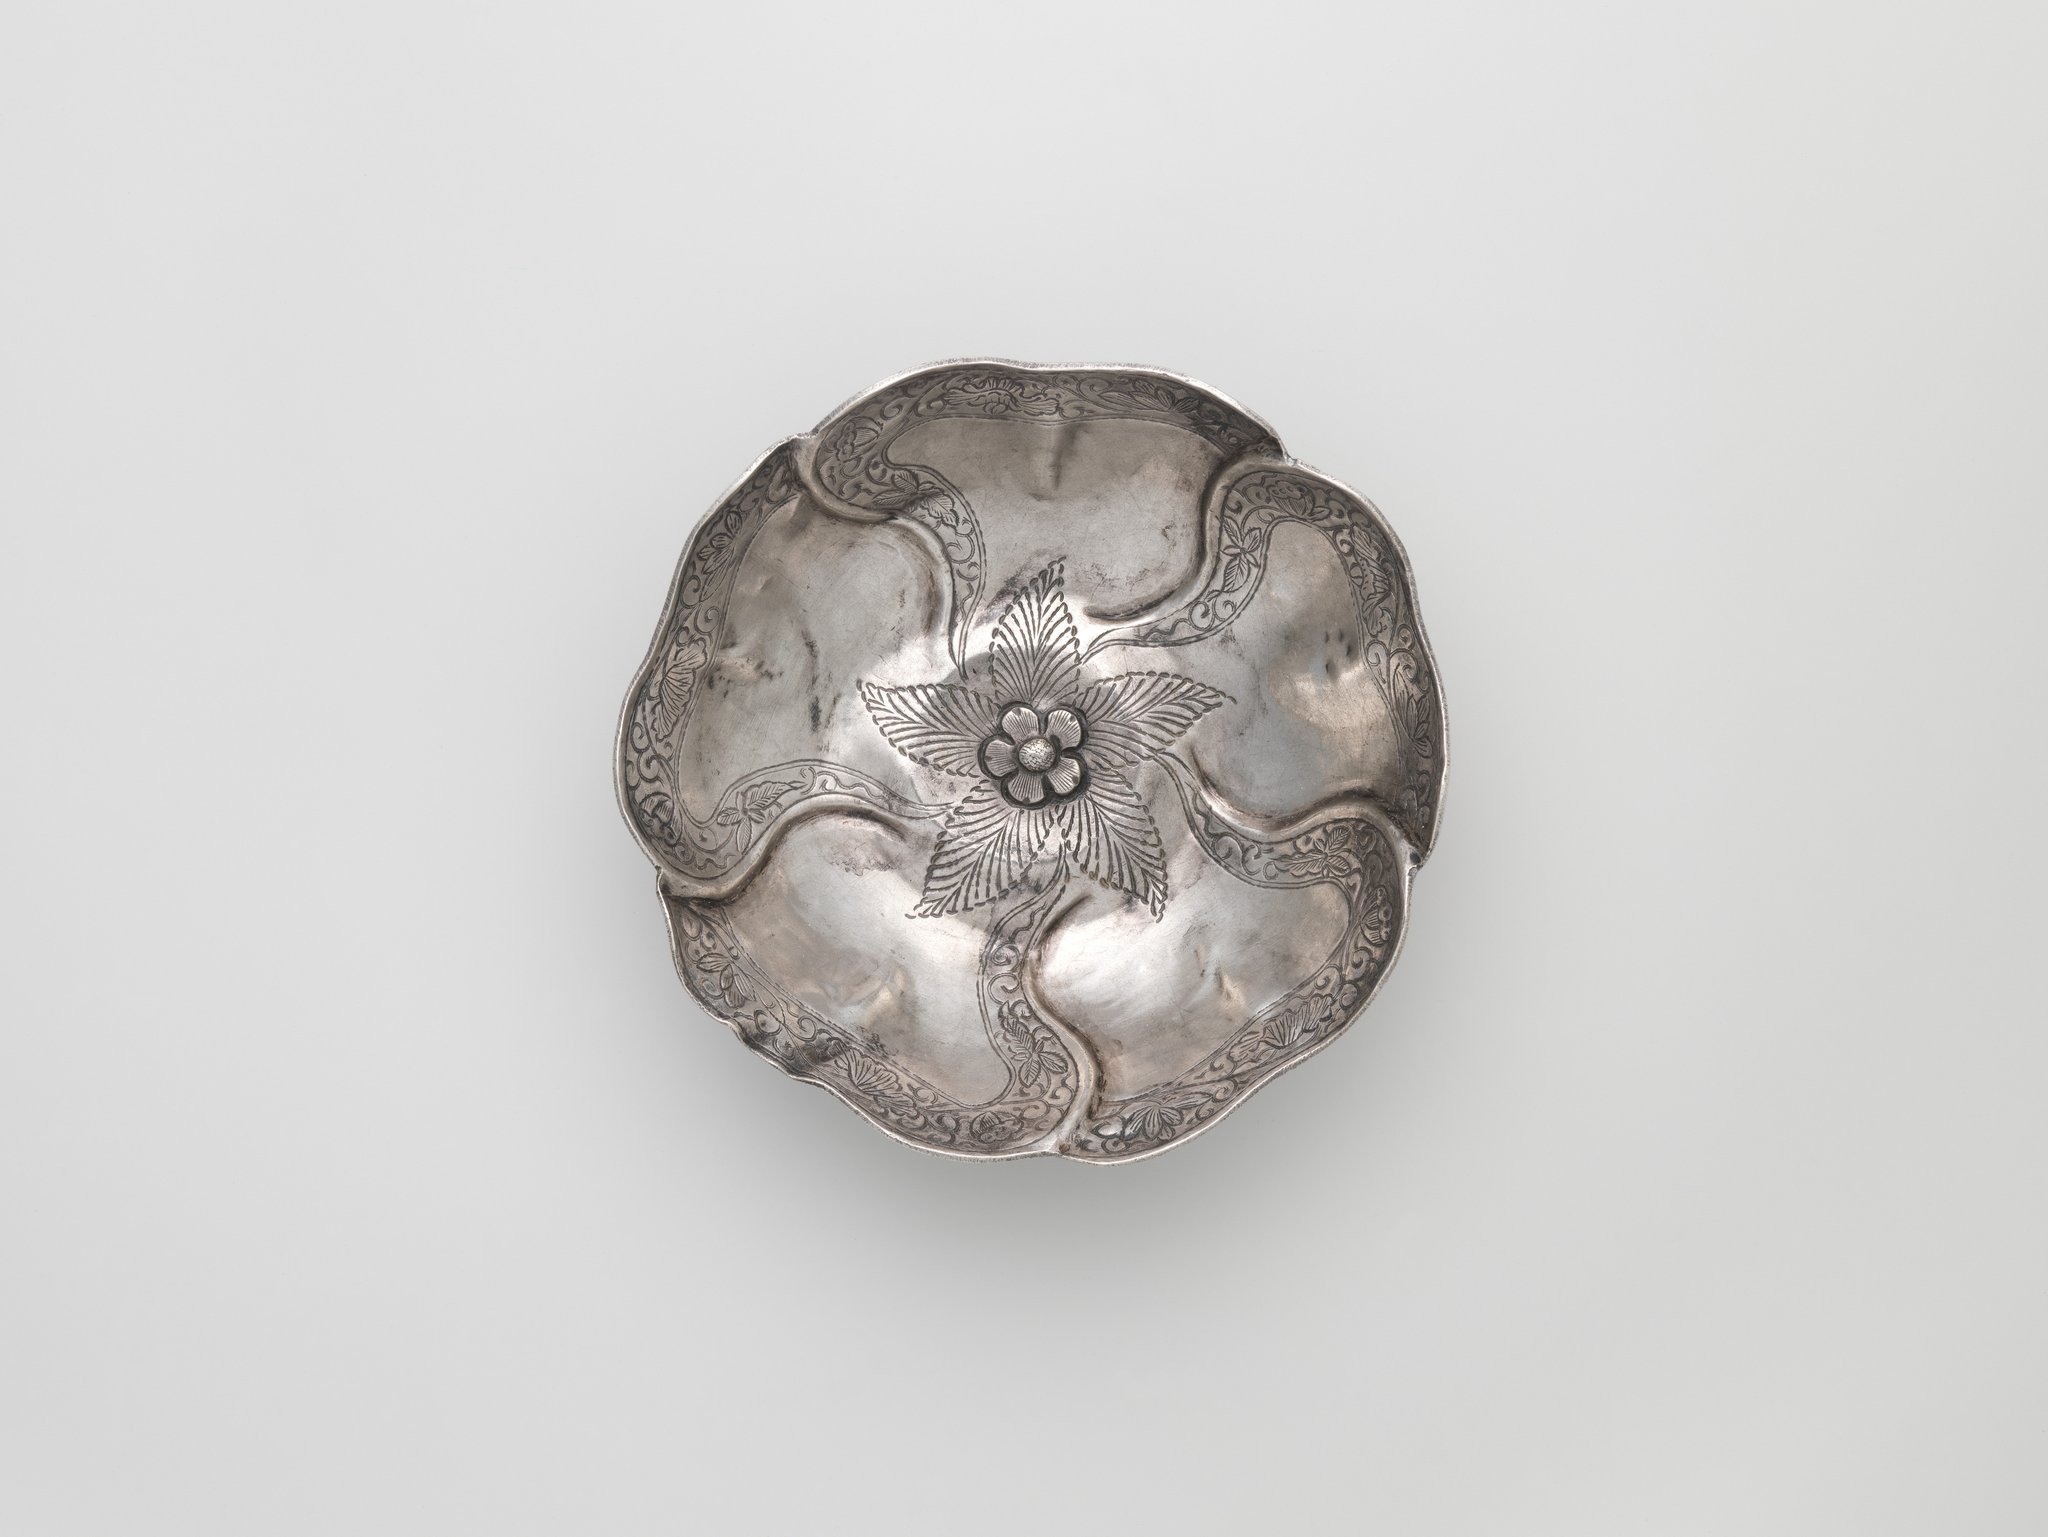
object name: cup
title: Cup with Floral Scrolls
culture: chinese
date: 1167-1200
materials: silver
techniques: chasing, repoussé